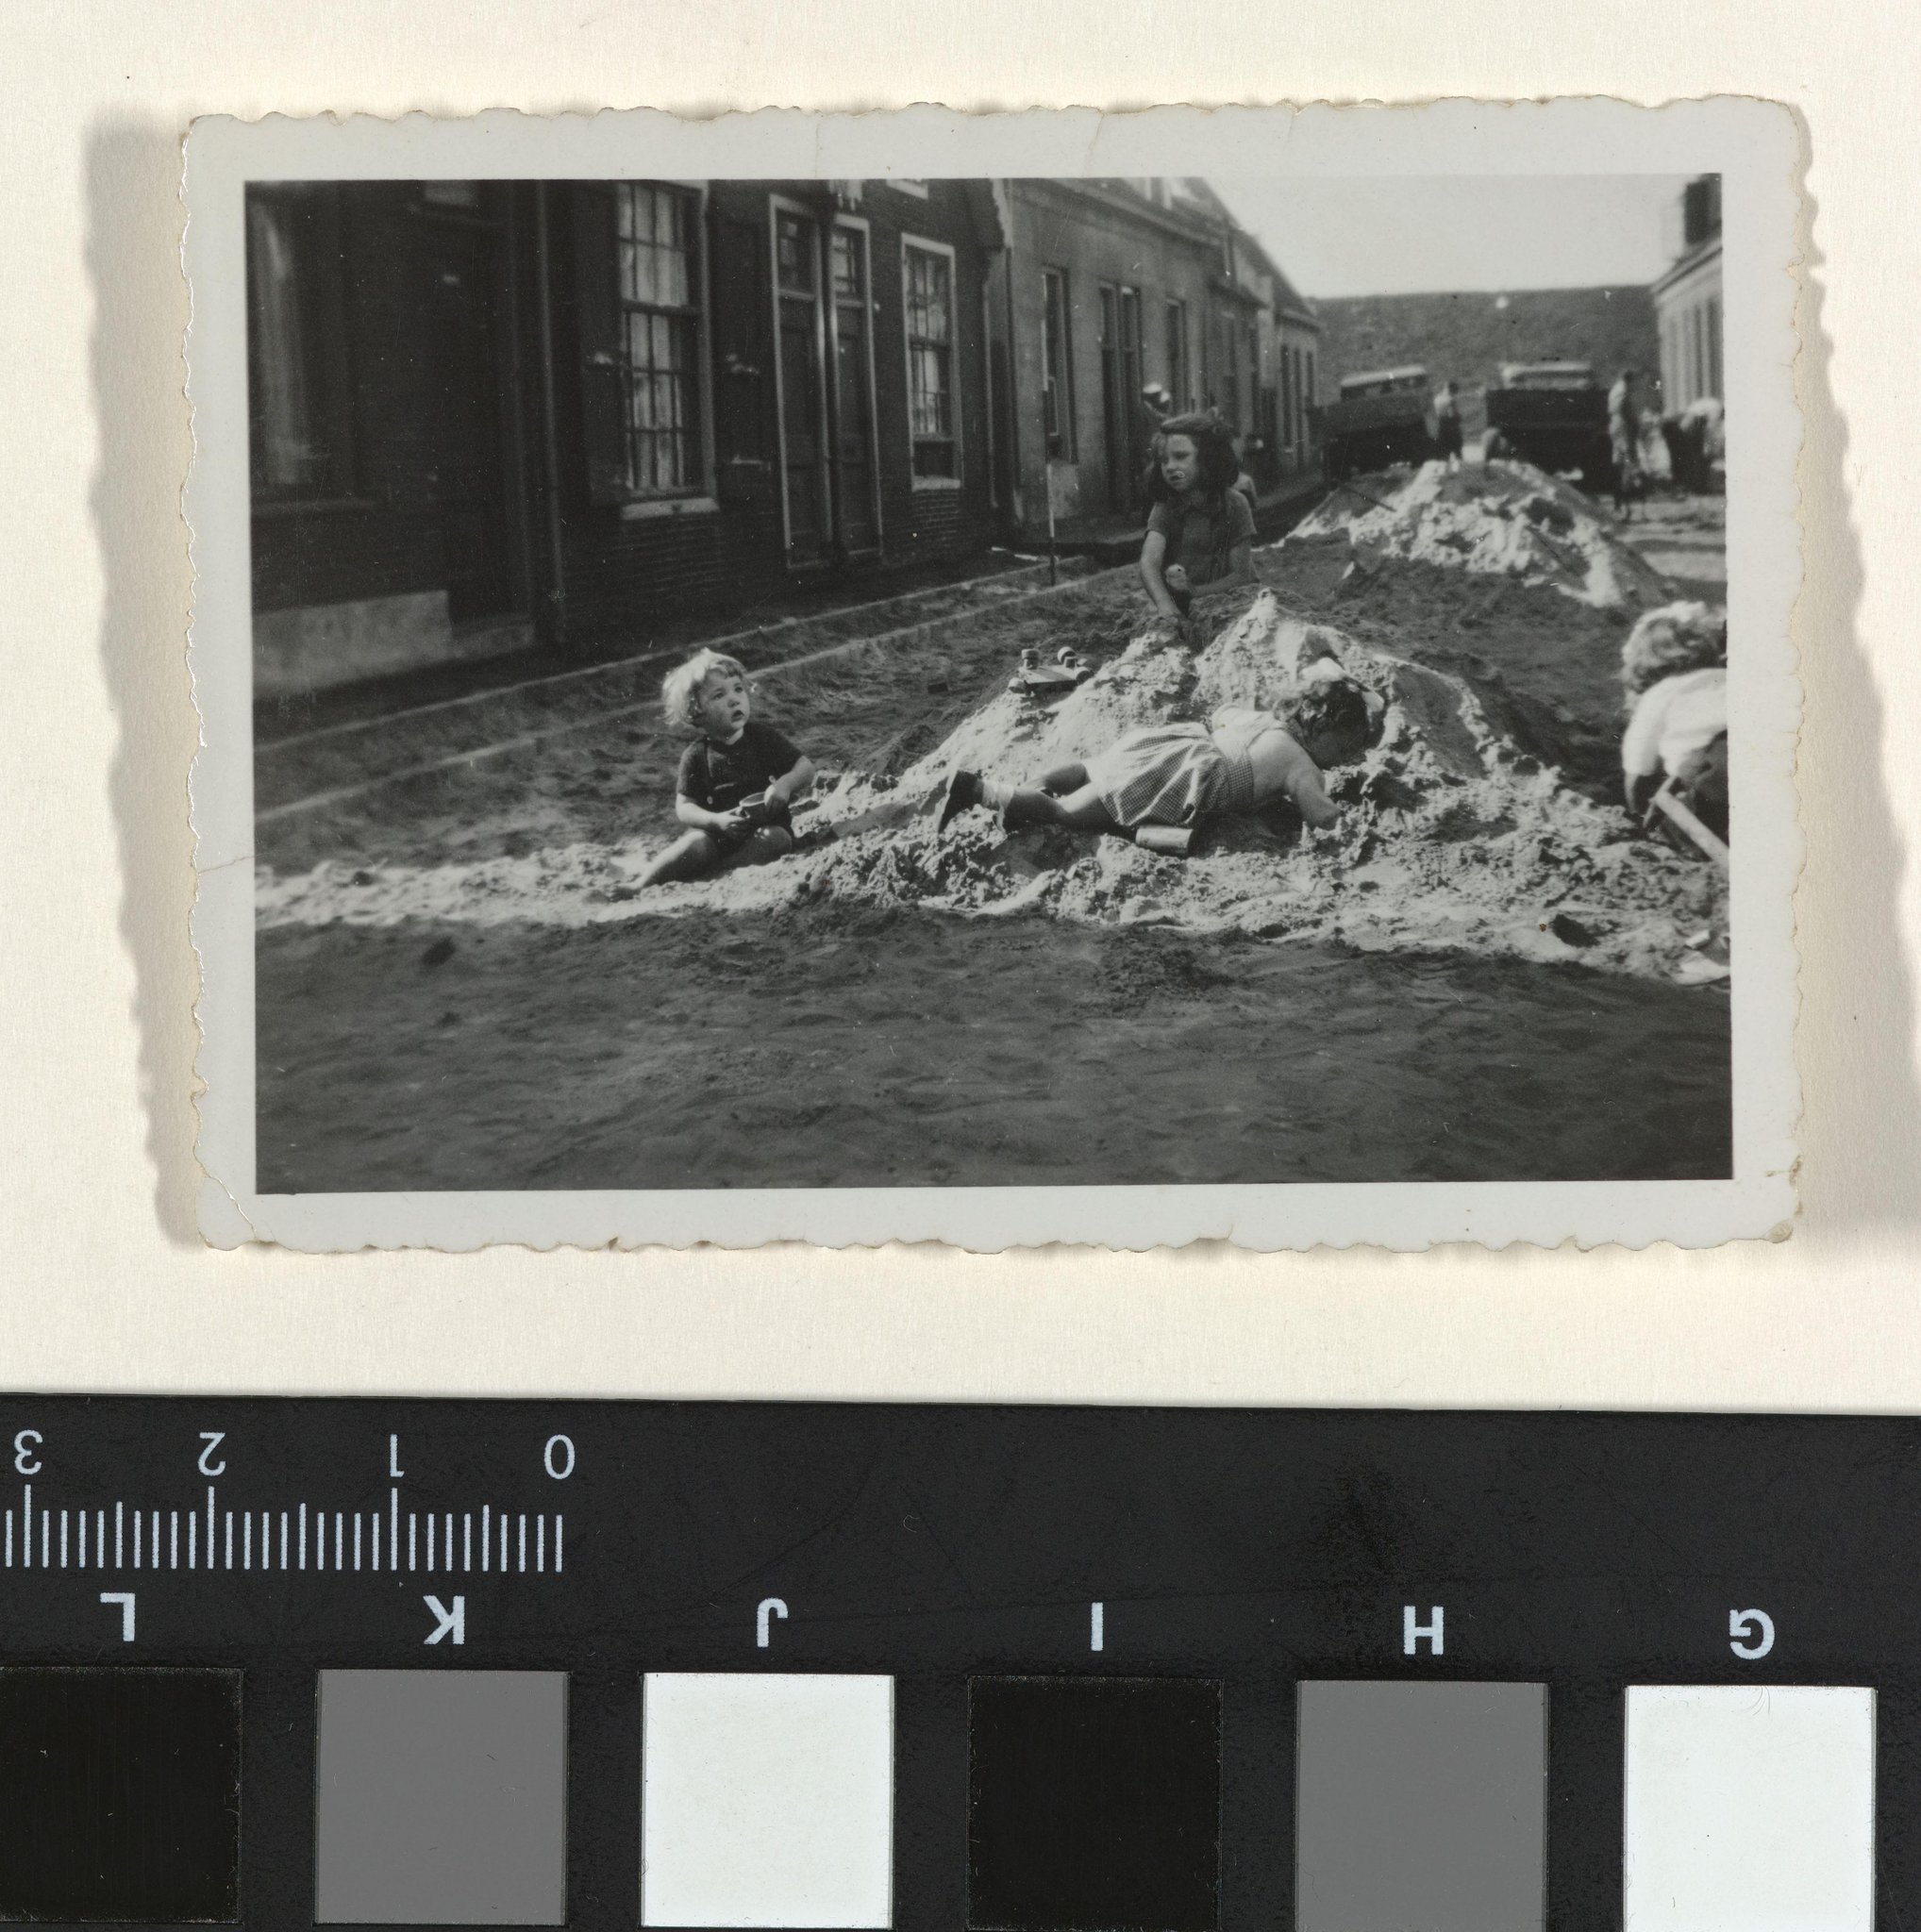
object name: photograph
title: Kinderen spelend in het zand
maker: Anonymous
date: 1925-1950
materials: paper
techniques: gelatin silver print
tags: children's games and plays, building-site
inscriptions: number: ‘3217’, inscription: ‘AP’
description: Kinderen spelend in het zand dat voor een rij huizen ligt. Op de achtergrond zijn twee werkauto's te zien.